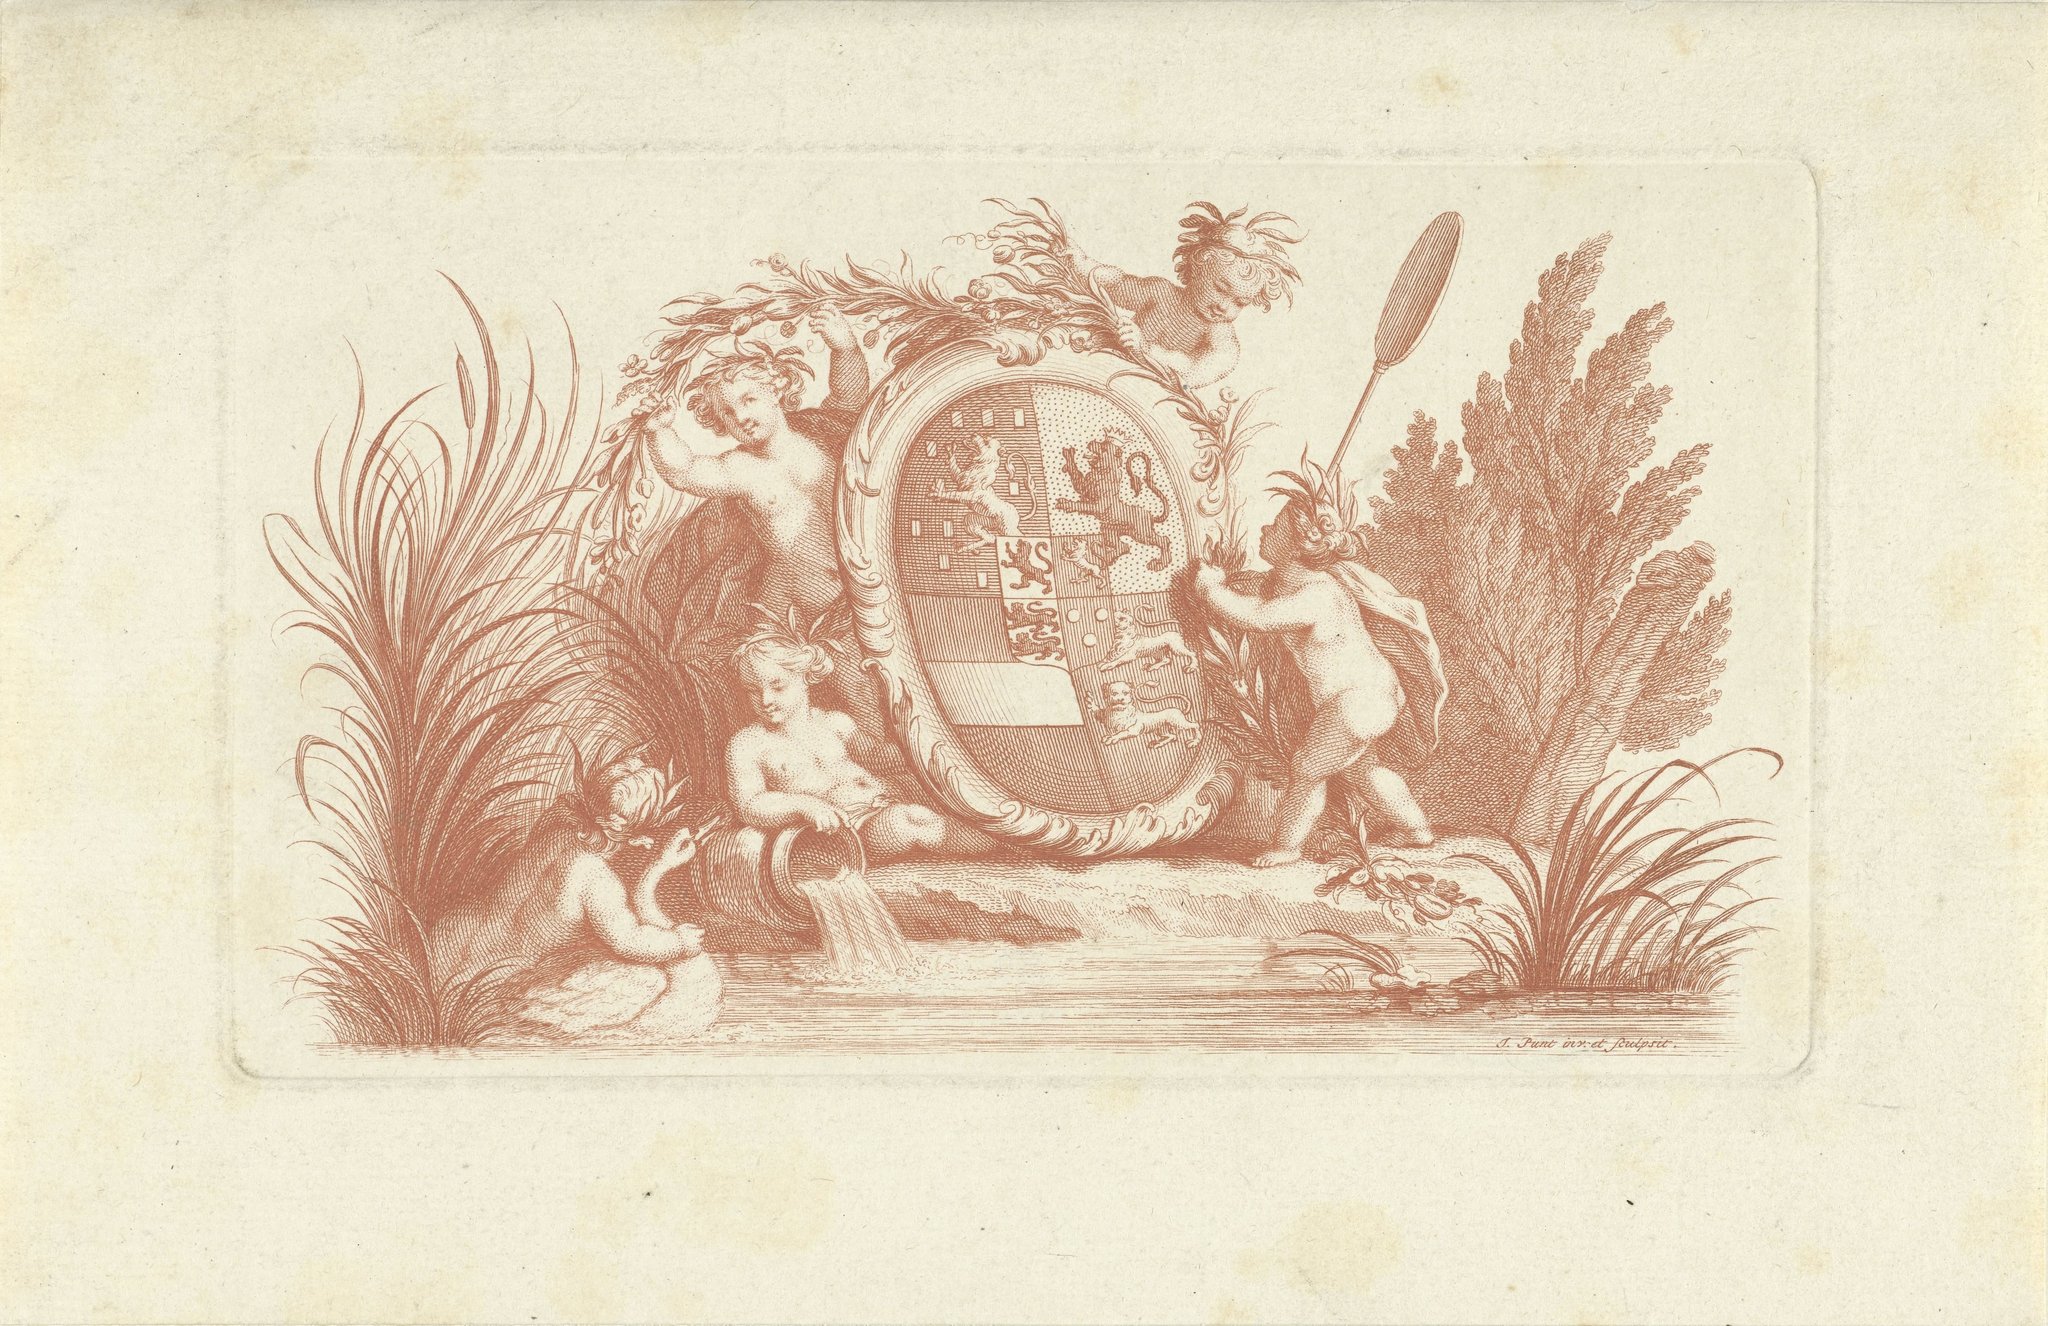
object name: print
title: Wapen van stadhouder Willem IV, 1747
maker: jan punt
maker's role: draughtsman, print maker, publisher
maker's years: 1711-1779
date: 1747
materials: paper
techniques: engraving, etching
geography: amsterdam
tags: the hague, willem iv (prins van oranje-nassau), armorial bearing, heraldry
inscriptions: collector's mark: Lugt 2760, collector's mark: Lugt 2228, inscription: ‘f. 157’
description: Het wapen van stadhouder Willem IV omringd door spelende naakte engeltjes aan de waterkant. Mogelijk naar aanleiding van de verheffing van Willem IV tot erfstadhouder in 1747.